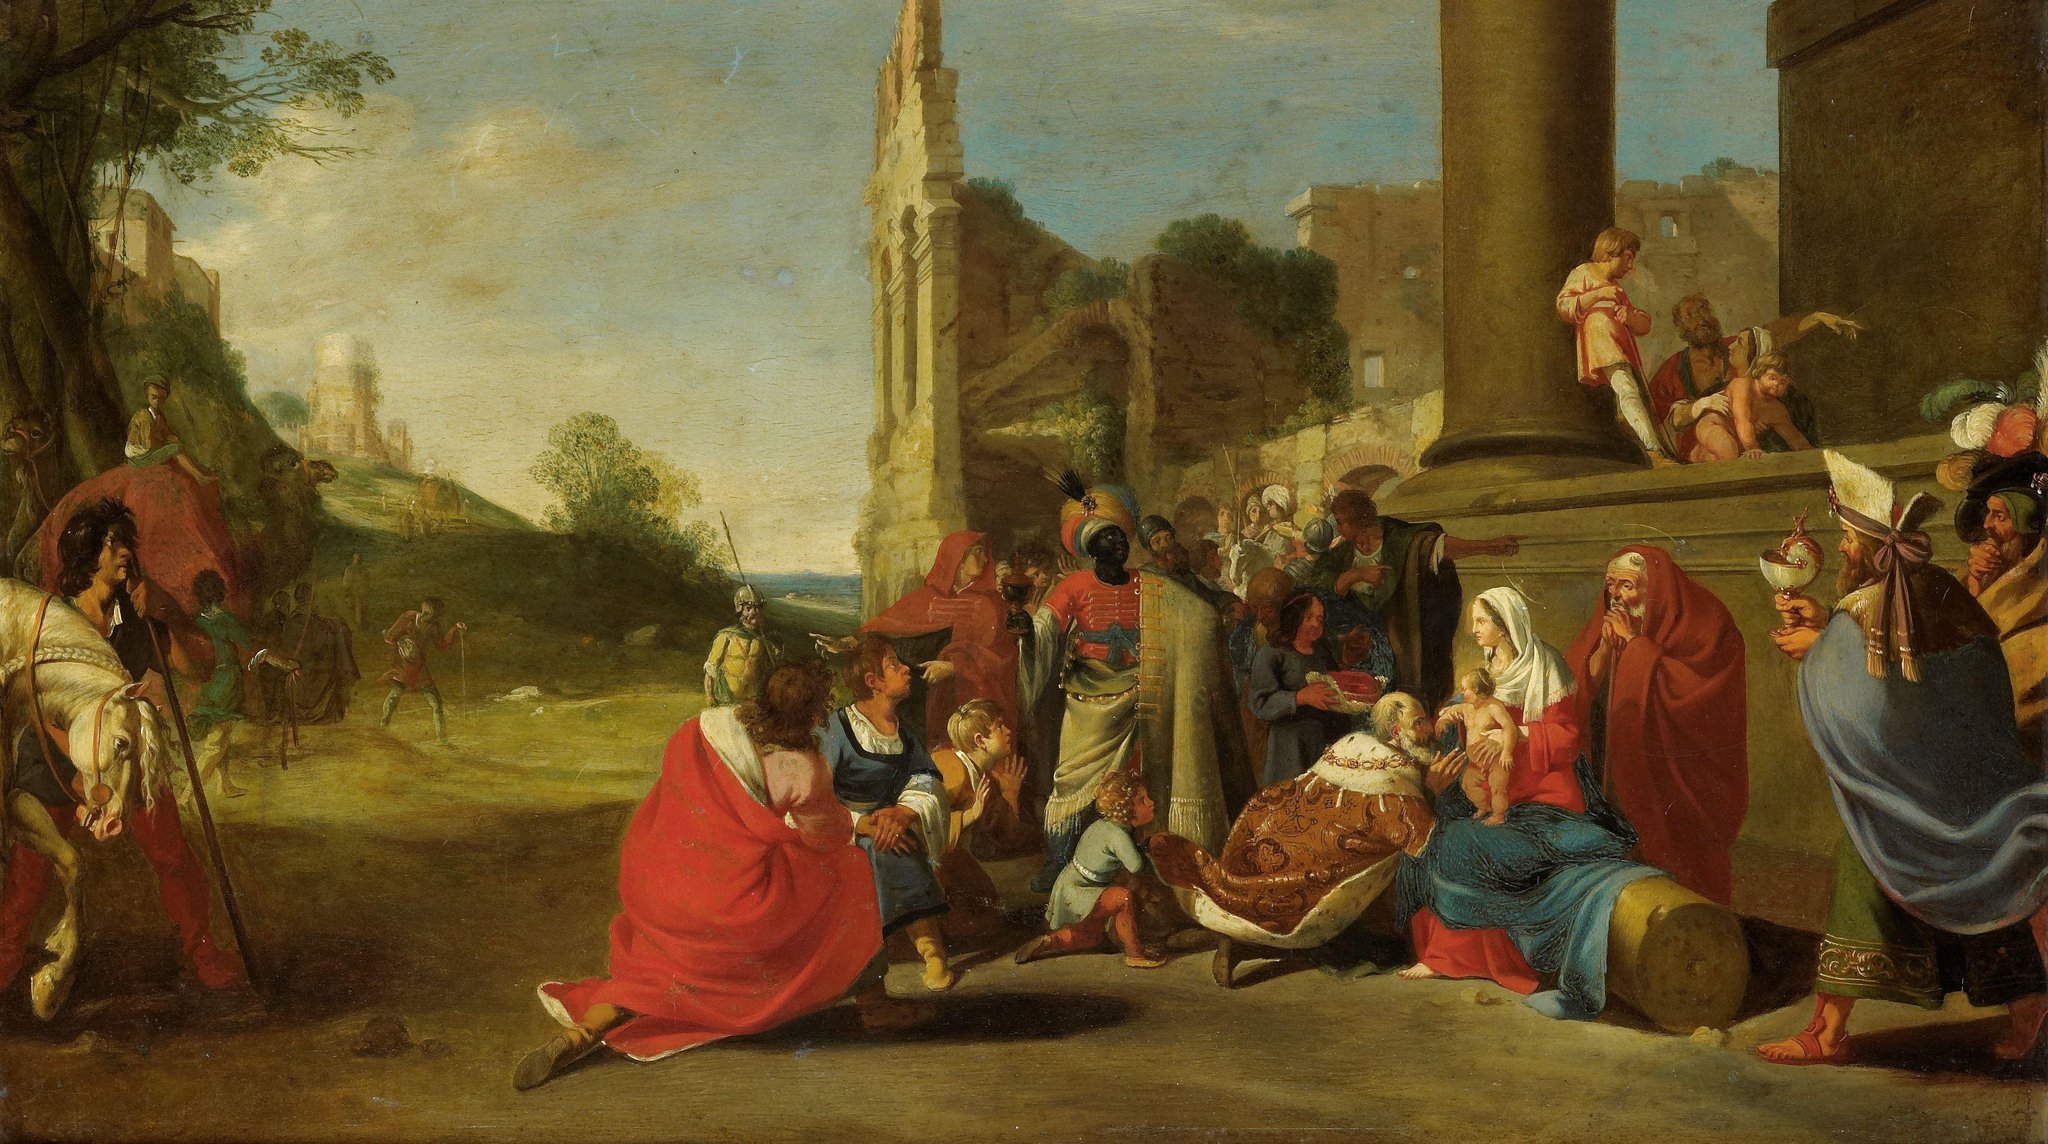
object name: painting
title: The Adoration of the Magi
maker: bartholomeus breenbergh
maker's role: draughtsman, print maker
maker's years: 1599-1657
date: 1640-1650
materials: copper, oil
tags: adoration of the kings: the wise men present their gifts to the christ-child (gold, frankincense and myrrh)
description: De aanbidding der koningen. De koningen en herders hebben zich rond de Heilige Familie verzameld bij een ruïne van een tempel. Rechts nadert een koning met in zijn handen een nautilusbeker.